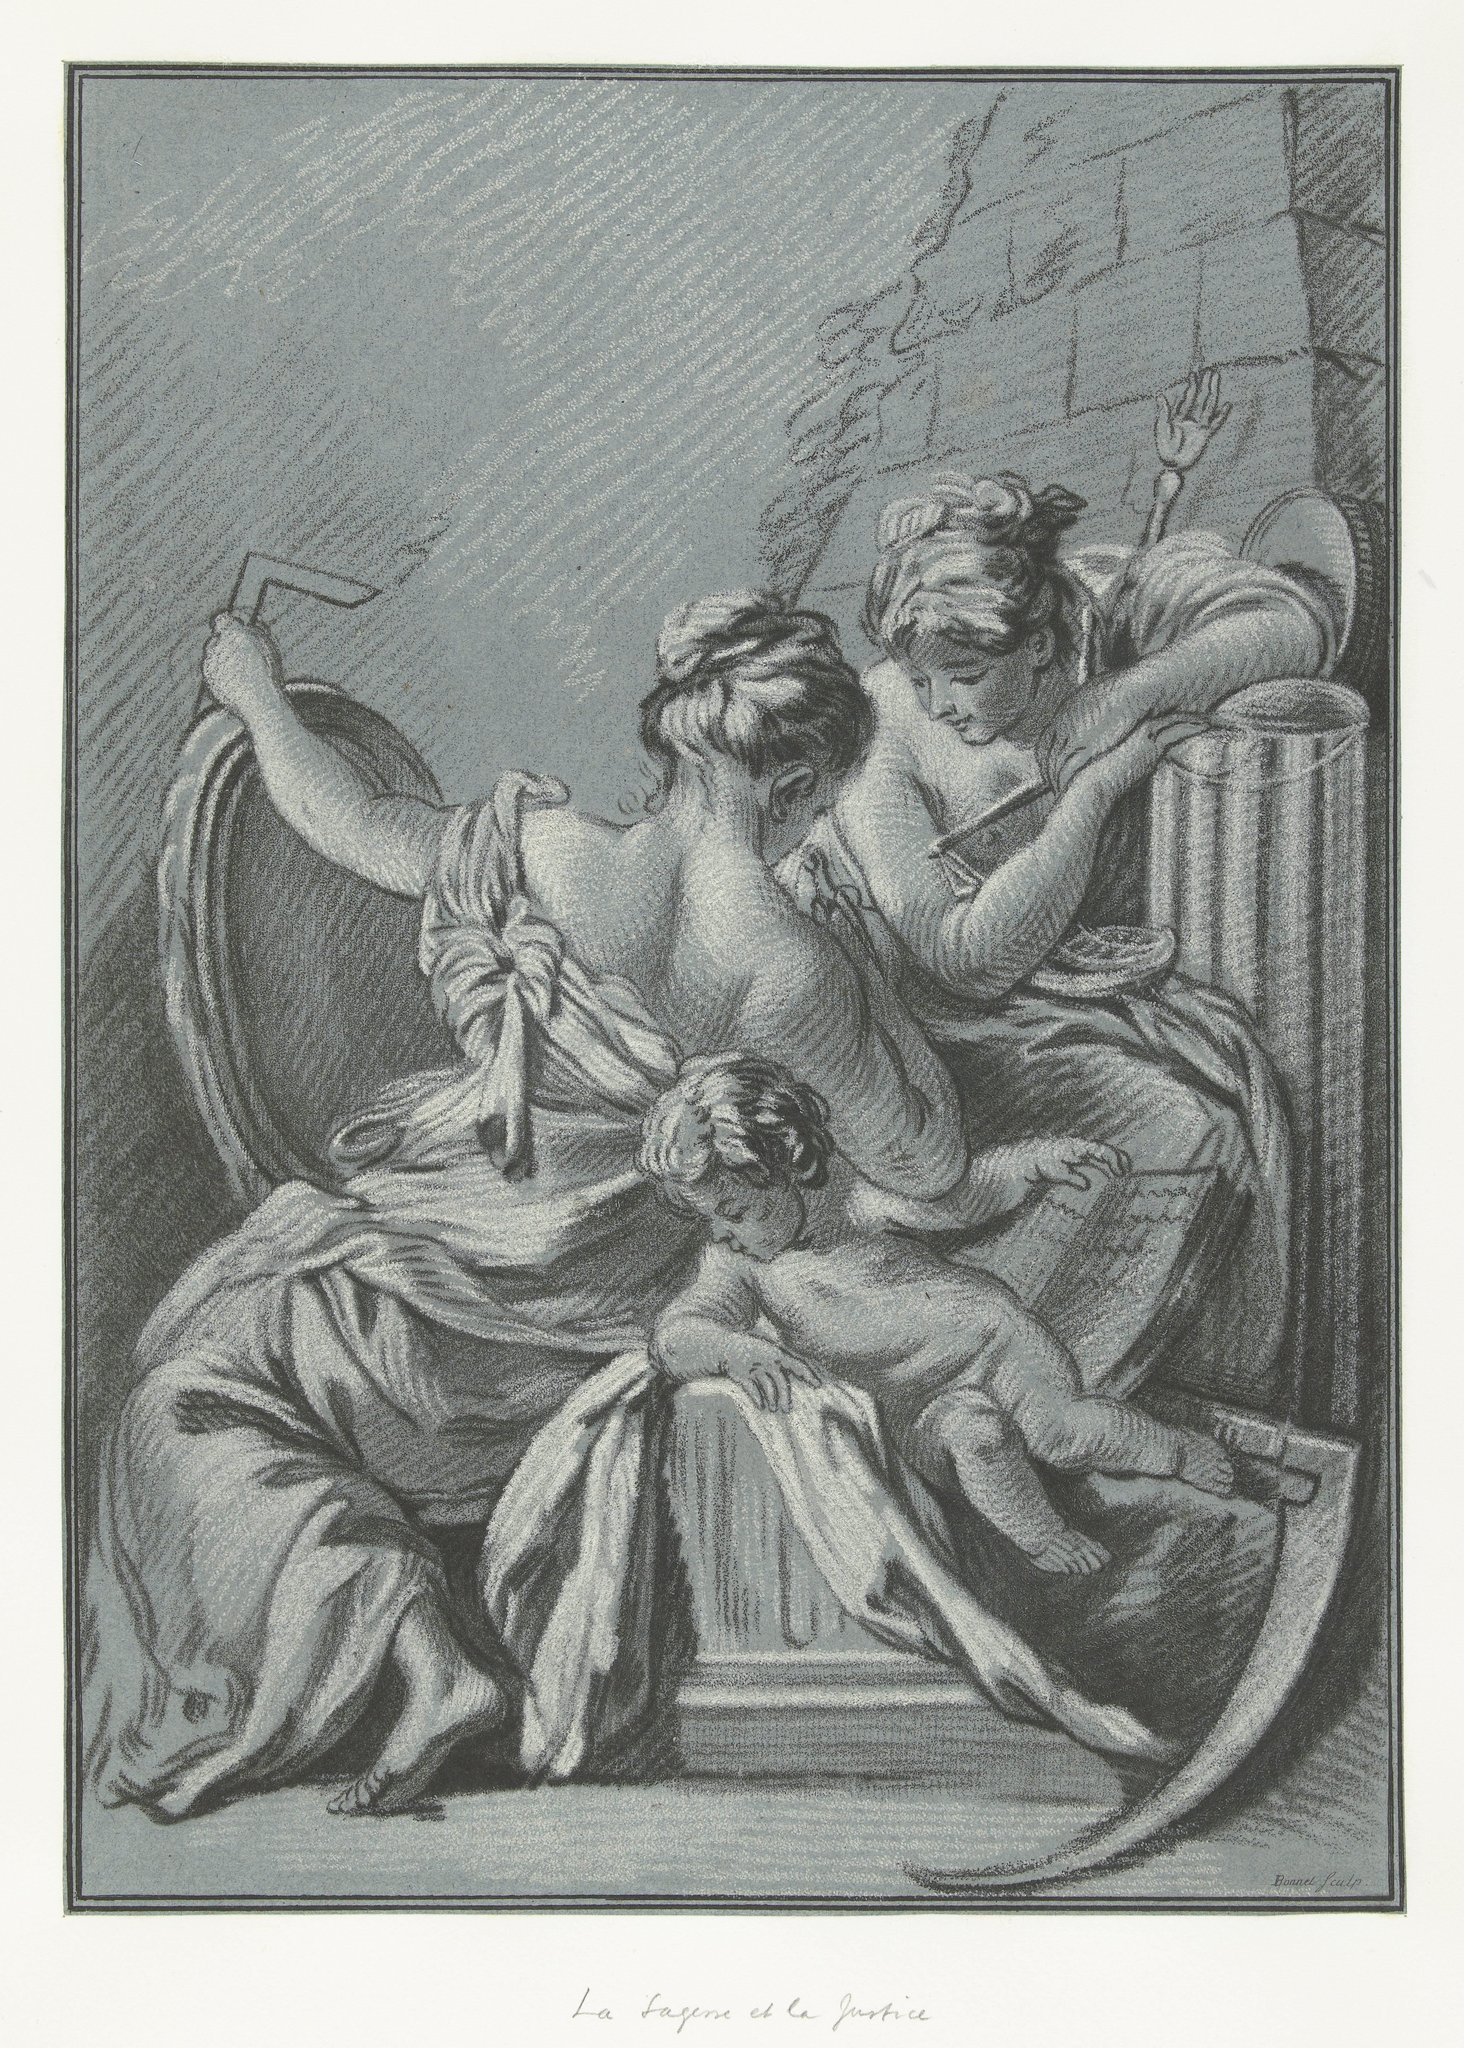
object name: print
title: La Sagesse et la Justice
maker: louis marin bonnet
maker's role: print maker, publisher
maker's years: 1736-1793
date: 1771-1772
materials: paper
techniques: printing, printmaking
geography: france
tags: wisdom; 'sapienza', 'sapienza humana', 'sapienza vera' (ripa) (+ abstract concept represented by female figure), justice; 'forza alla giustitia sottoposta', 'giustitia', 'giustitia retta', 'giustitia rigorosa', 'impietà e violenza soggetta alla giustitia' (ripa) (+ abstract concept represented by female figure)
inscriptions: collector's mark: Lugt 2228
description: Een vrouw op de rug gezien, personificatie van de Wijsheid, met een spiegel en een passer in haar handen. Een tweede vrouw, van voren gezien, leunend op een zuil, een weegschaal in haar handen. Een jongetje met een open boek en een zeis zit bij de twee vrouwen.